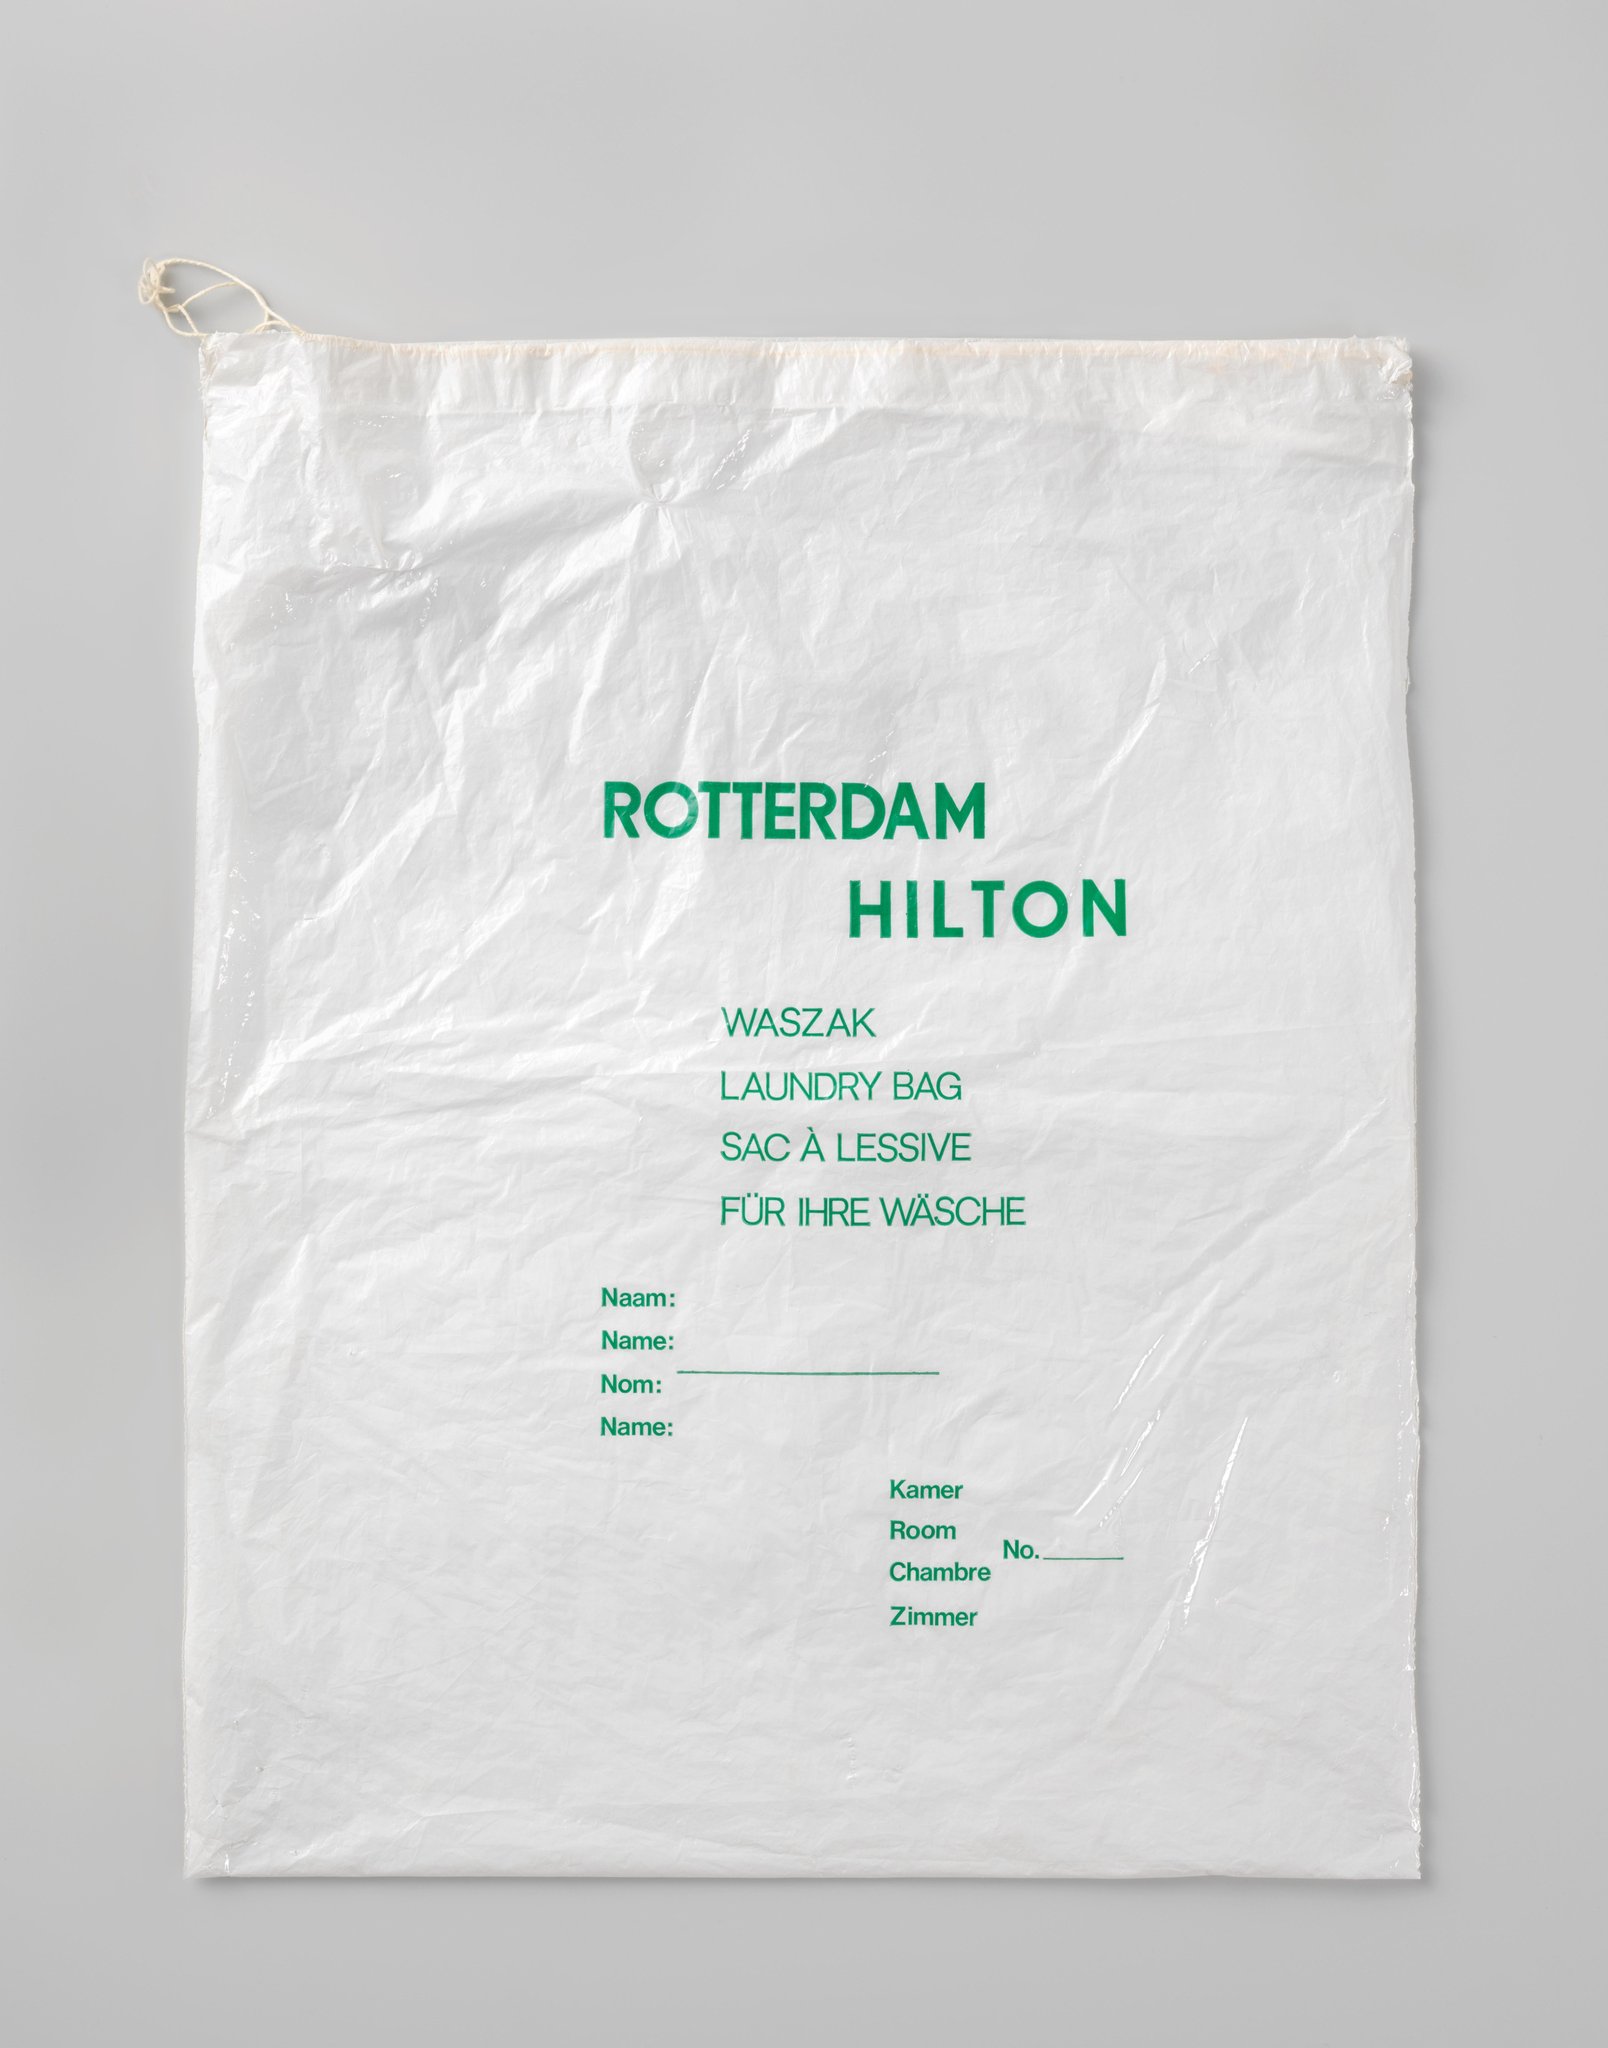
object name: covering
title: Hoes voor concentratiekampjas van Isabel Wachenheimer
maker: Anonymous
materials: plastic, textile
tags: leiden, isabel wachenheimer-elon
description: Plastic hoes van de Hilton Rotterdam waarin Isabel Wachenheimer in de jaren na het einde van de Tweede Wereldoorlog haar concentratiekampjas heeft bewaard.